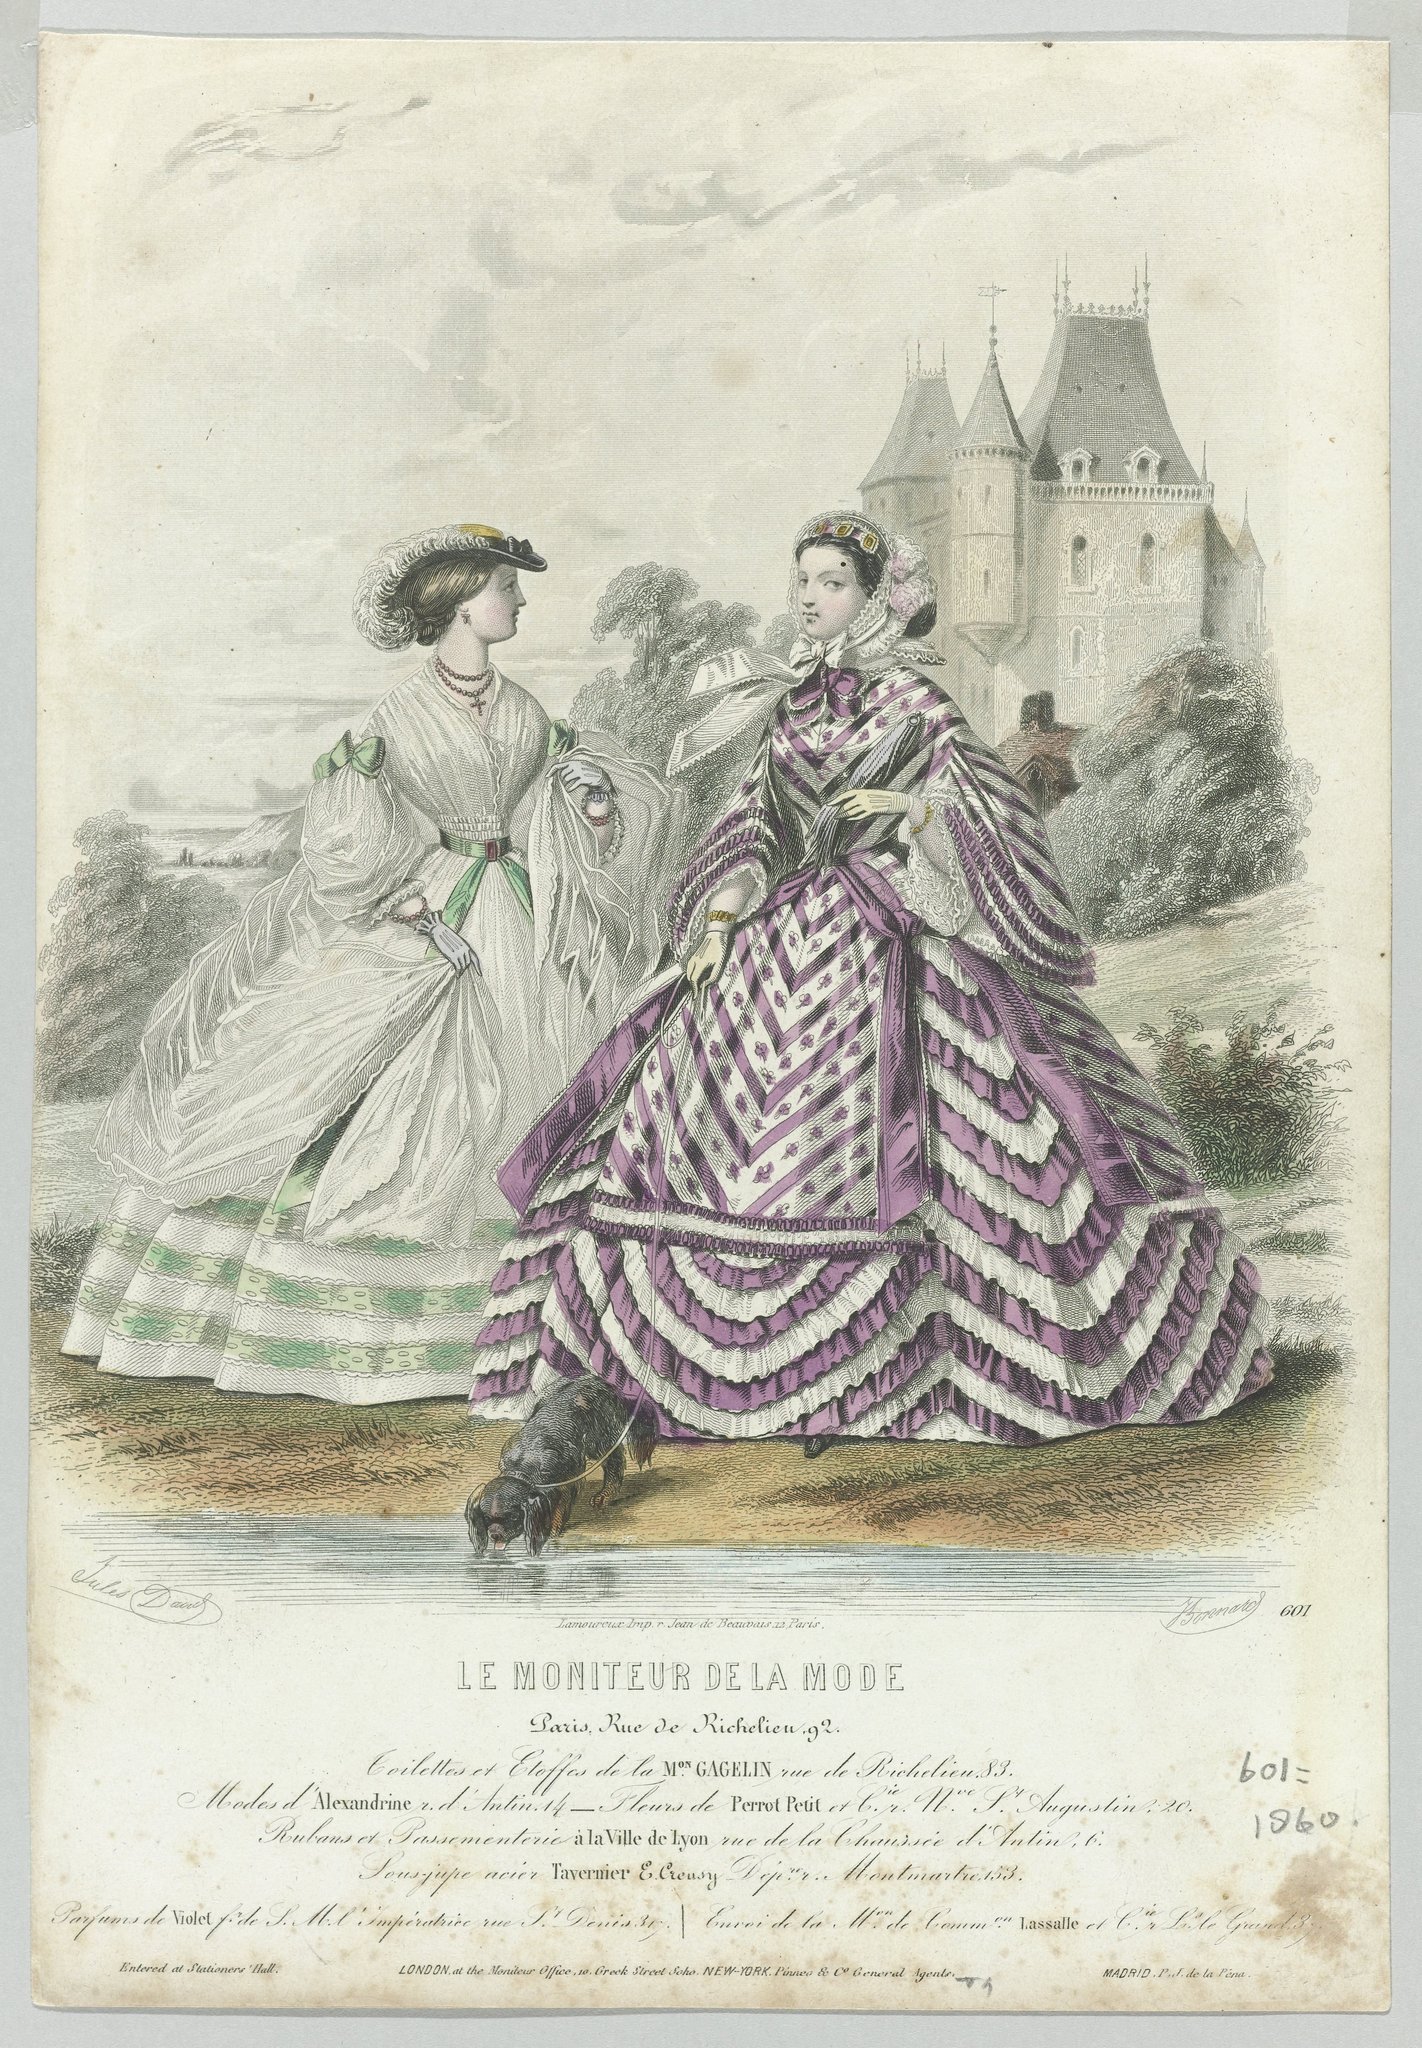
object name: fashion print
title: Le Moniteur de la Mode, 1860, No. 601: Toilettes et Etoffes (...)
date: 1860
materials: paper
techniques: hand coloring, engraving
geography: paris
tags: ear-rings (+ women's clothes), ornamental parts of clothing (+ women's clothes), dog (+ animals eating and drinking), fashion plates, head-gear: hat (+ women's clothes), gloves, mittens, etc. (+ women's clothes), landscape with tower or castle, bracelet, wristlet (+ women's clothes), necklace (+ women's clothes), parasol, sunshade (+ women's clothes)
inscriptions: caption: ‘Toilettes et Etoffes de la M.on Gagelin rue de Richelieu, 83. Modes d'Alexandrine r. d'Antin, 14_ Fleurs de Perrot Petit et C.ie r. N.ve S.t Augustin, 20. Rubans et Passementerie à la Ville de Lyon rue de la Chaussée d'Antin, 6. Sous-jupe acier Tavernier & Creusy Dép.re r. Montmartre 153. Parfums de Violet f.r de S.M. l'Impératrice rue S.t Denis 317. Envoi de la M.on de Comm.on Lassalle et C.ie r L.s le Grand. 37’, address: ‘Paris, Rue de Richelieu, 92. / Entered at Stationers Hall London at the Moniteur Office, 10, Greek Street Soho. New York Pinneo & co General Agents Madrid P.J. de la Pena’, title: ‘Le Moniteur de la Mode’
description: Twee vrouwen in crinolinejaponnen met een hond bij een vijver. Volgens het onderschrift: 'toilettes' en stoffen van Maison Gagelin. 'Modes' van Alexandrine. Hieronder enkele regels reclametekst voor verschillende producten. Prent uit het modetijdschrift Le Moniteur de la Mode (1843-1913).